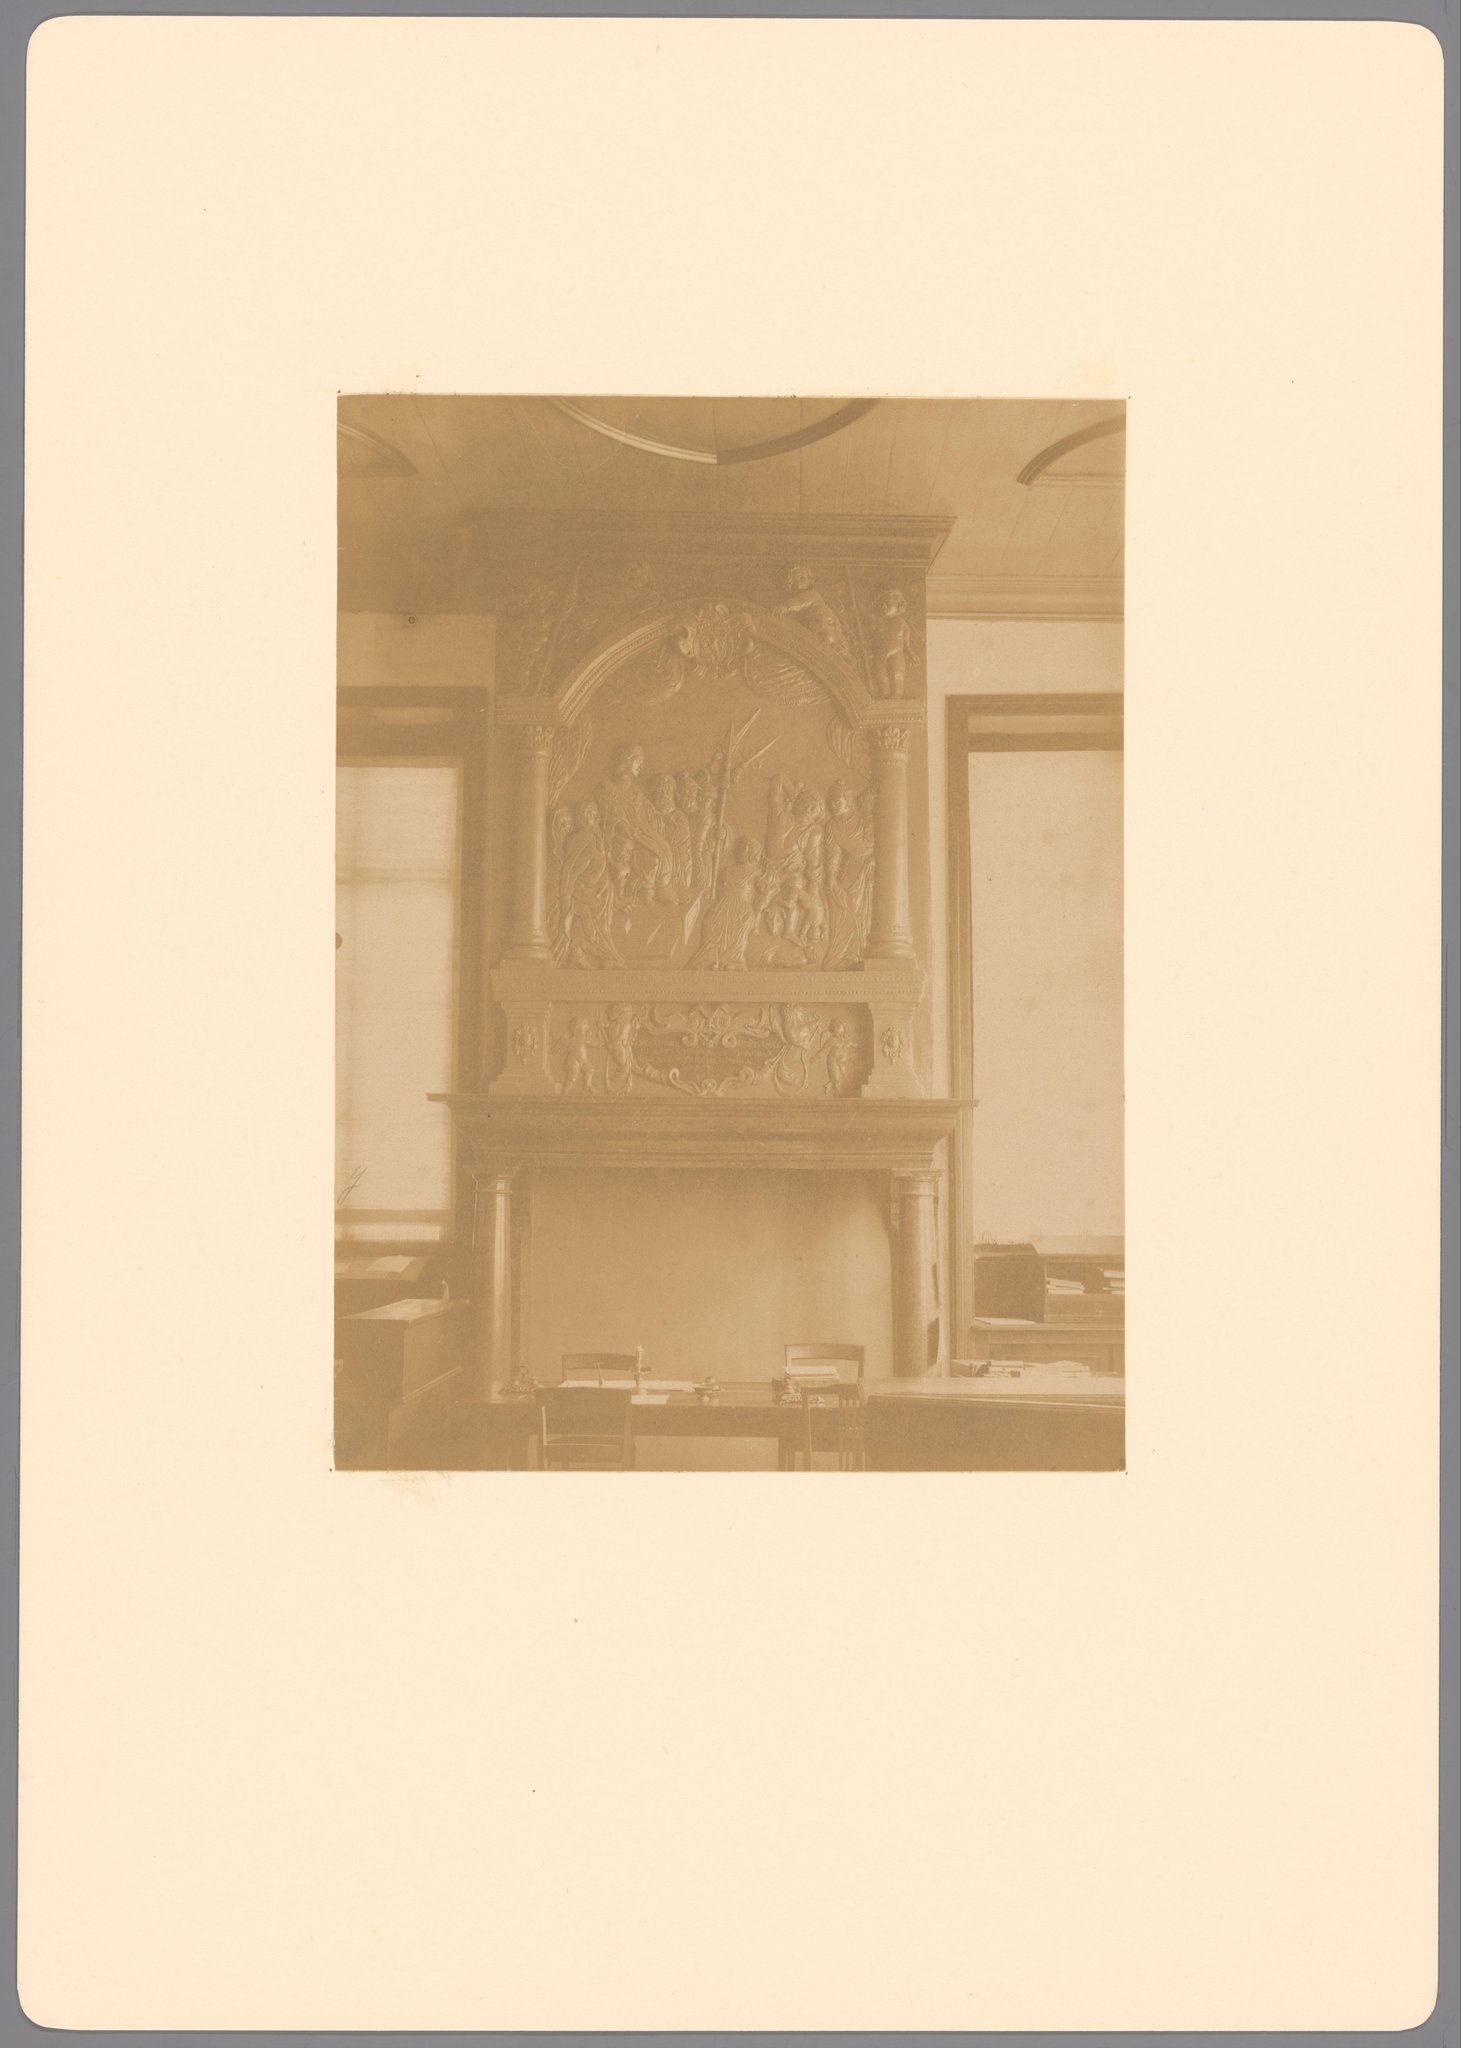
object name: photograph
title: Schoorsteen in het stadhuis te Doesburg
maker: anoniem (monumentenzorg)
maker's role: fotograaf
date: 1890-1920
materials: cardboard, photographic support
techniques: albumen print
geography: doesburg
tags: townhall, chimney-piece, mantelpiece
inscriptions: annotation: ‘Doesburg/ schoorsteen in de secretairie v/h raadhuis’